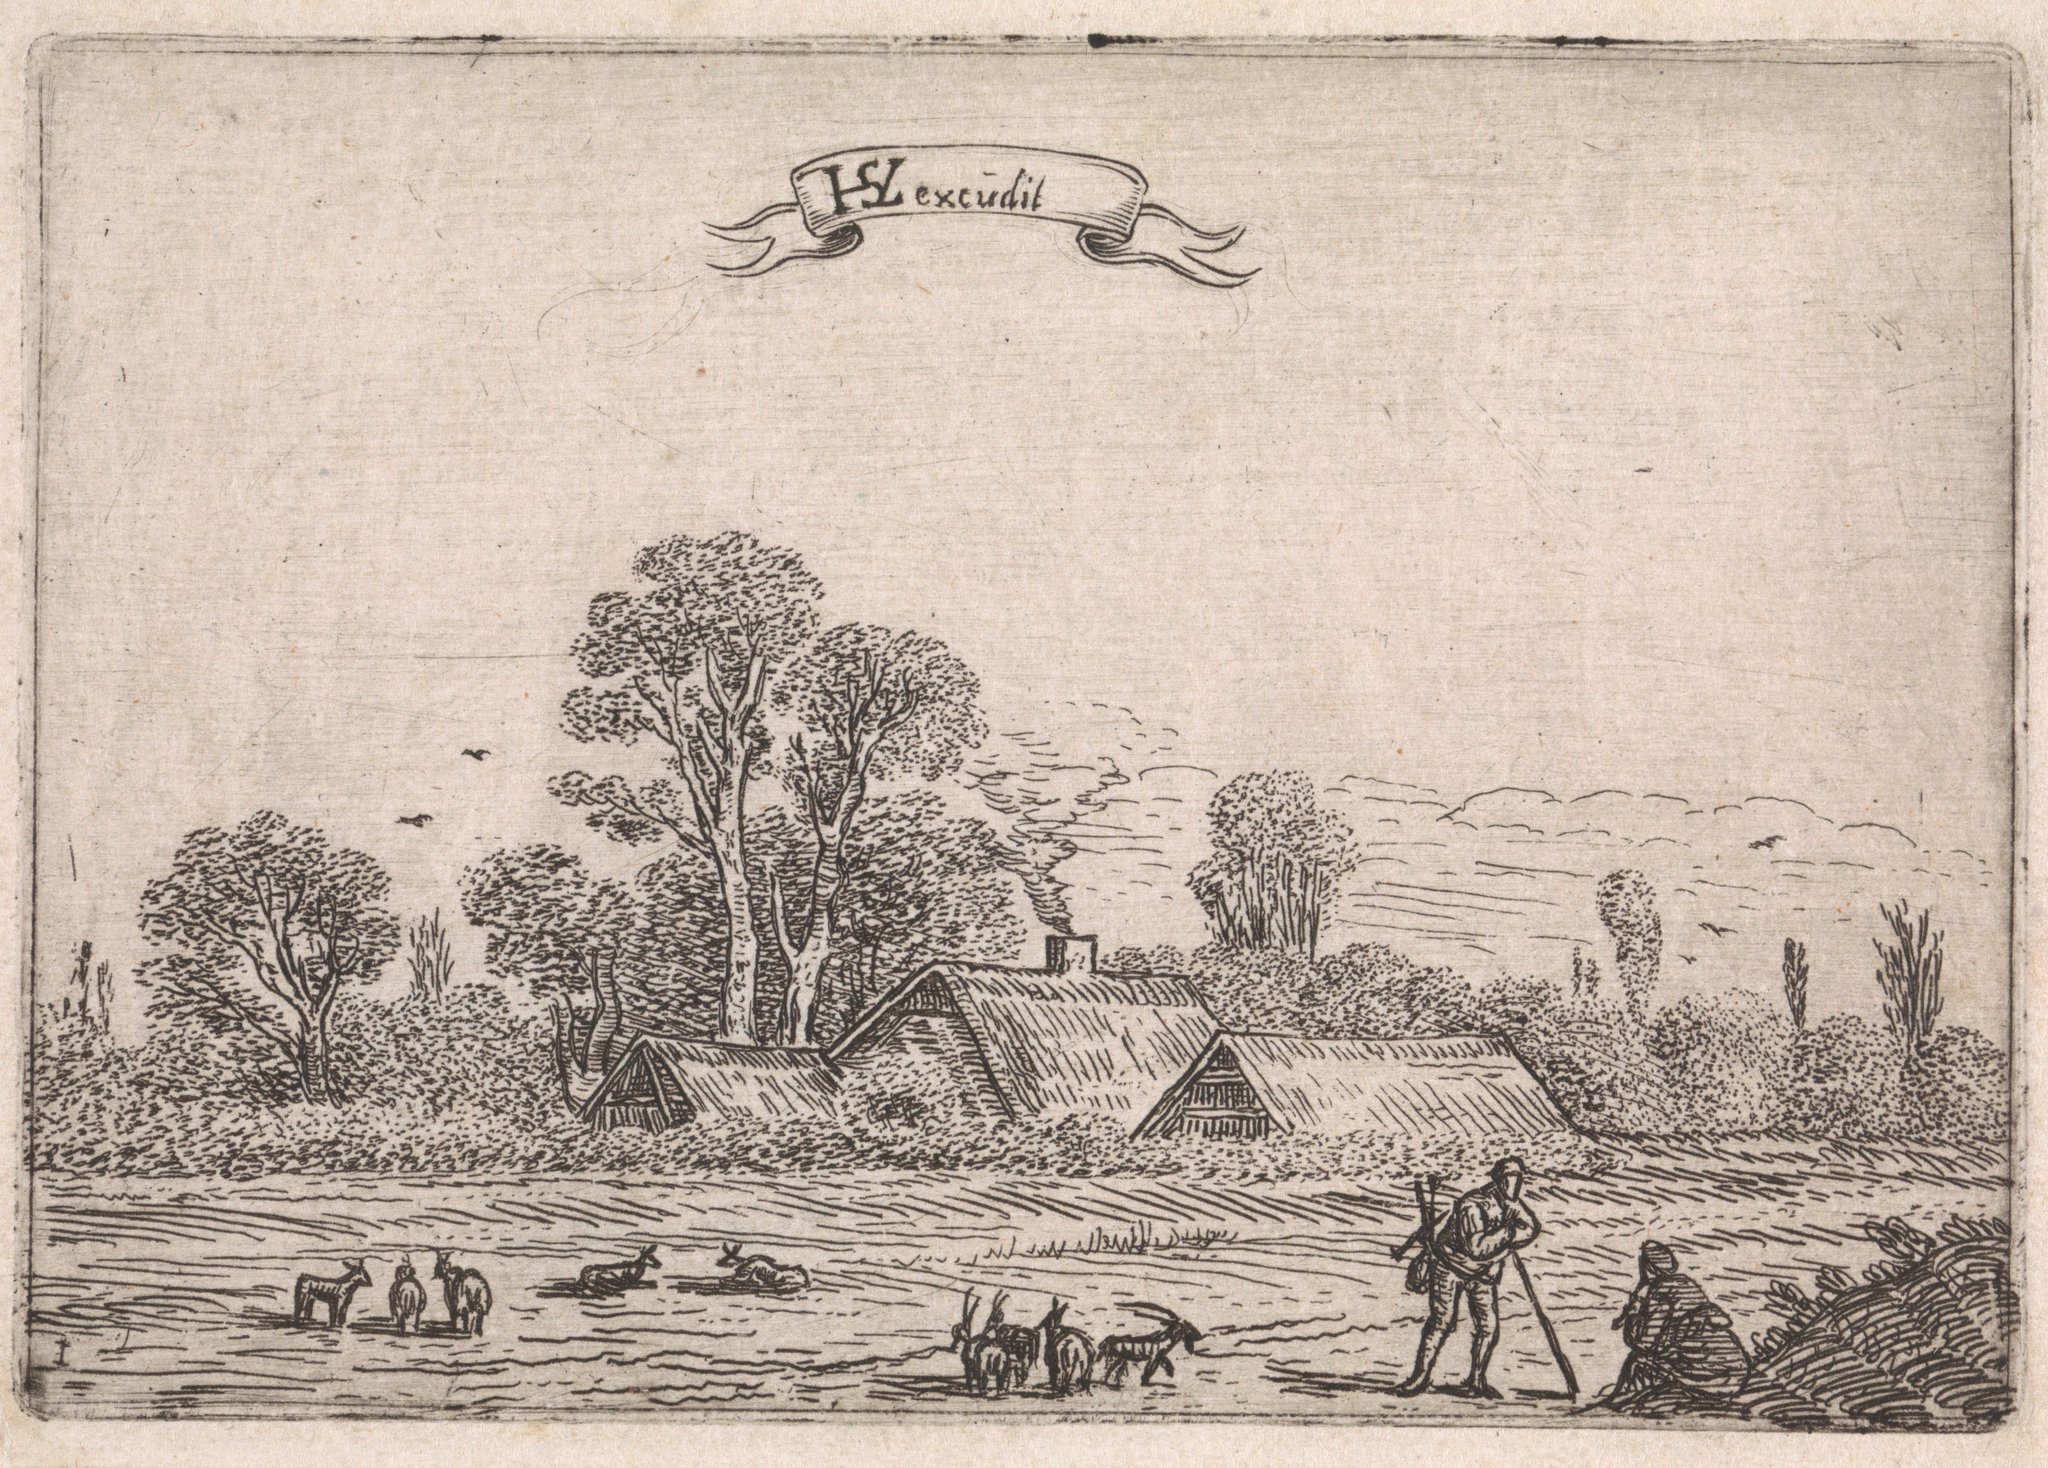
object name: print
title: Pratende mannen en vee op een veld voor een boerderij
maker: herman saftleven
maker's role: draughtsman, painter, print maker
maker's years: 1609-1685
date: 1627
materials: paper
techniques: etching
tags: conversation, dialogue; conversation piece, goat, farm or solitary house in landscape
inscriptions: collector's mark: Lugt 240